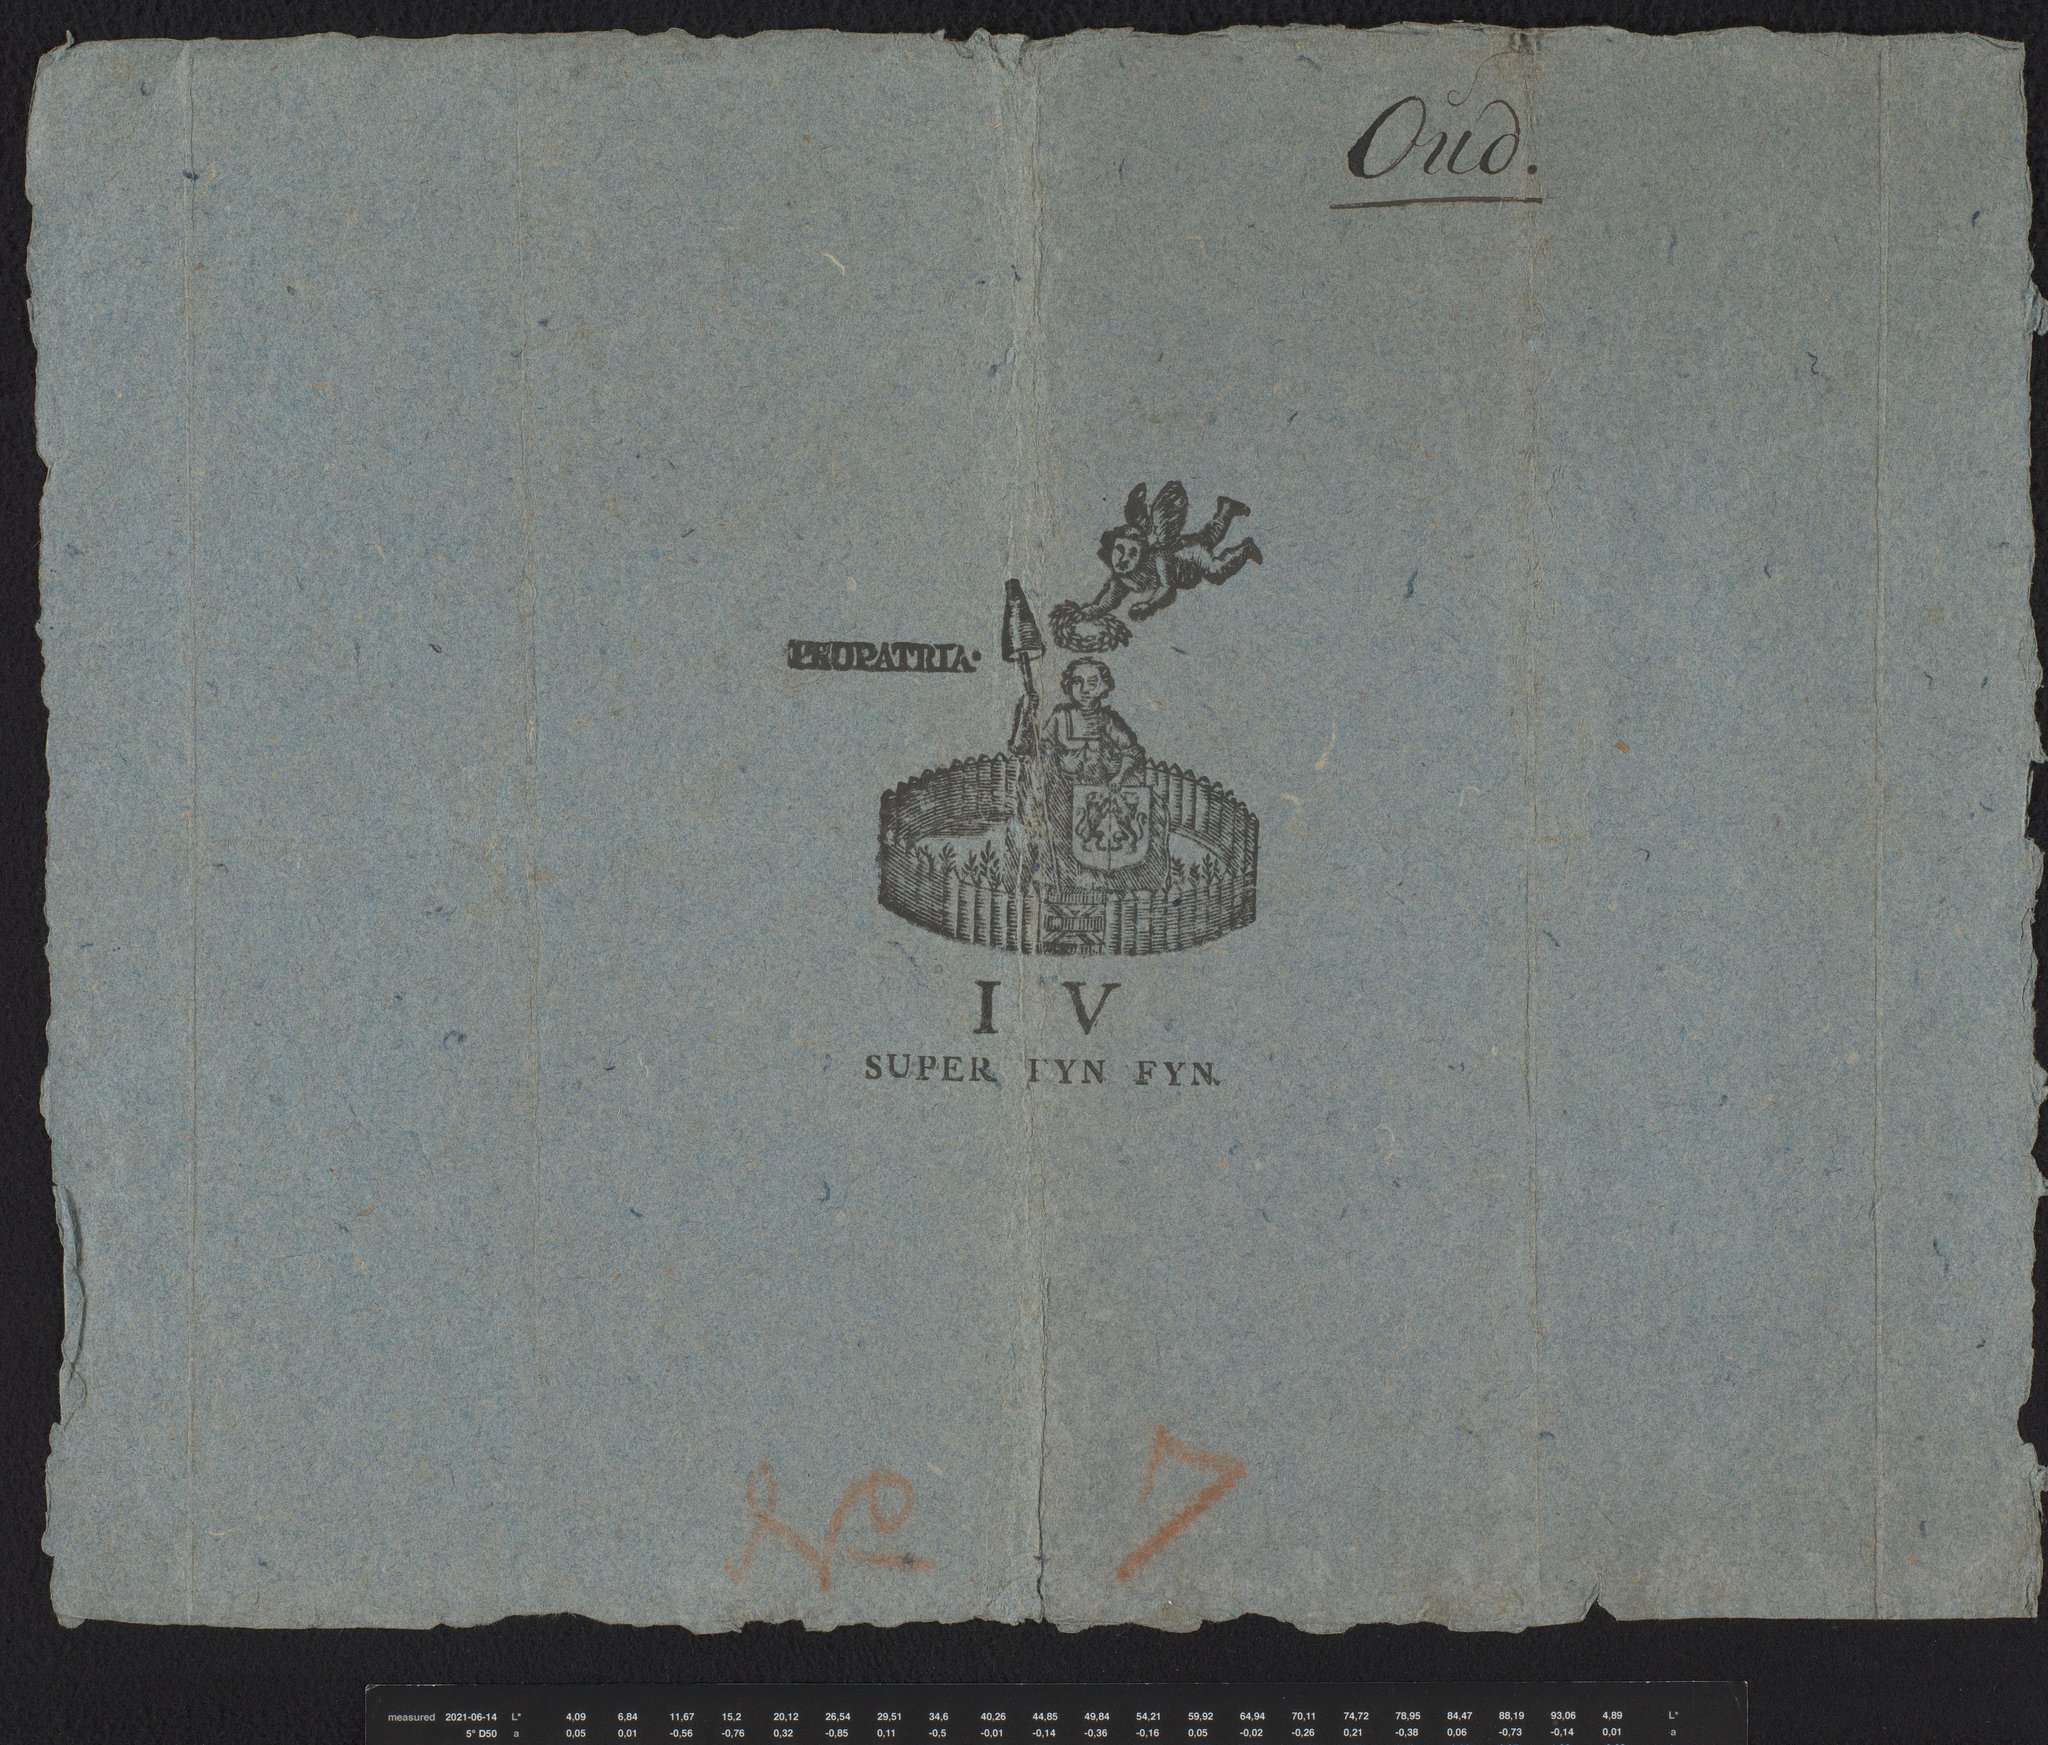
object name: print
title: Riemkap voor 'Pro Patria IV super fyn fyn'-papier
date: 1775-1800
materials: paper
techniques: letterpress printing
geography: veluwe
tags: personifications of countries, nations, states, districts, etc. (with name)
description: Een riemkap werd gebruikt om een riem papier te bedekken, en was vaak voorzien van een kwaliteitsaanduiding van het papier en initialen of naam van de papiermaker of papiermolen. Ongewoon is dat het merk en opschrift in het zwart gedrukt zijn. 'Super fijn fijn' is de aanduiding van de papiersoort, in dit geval het betere soort schrijfpapier.